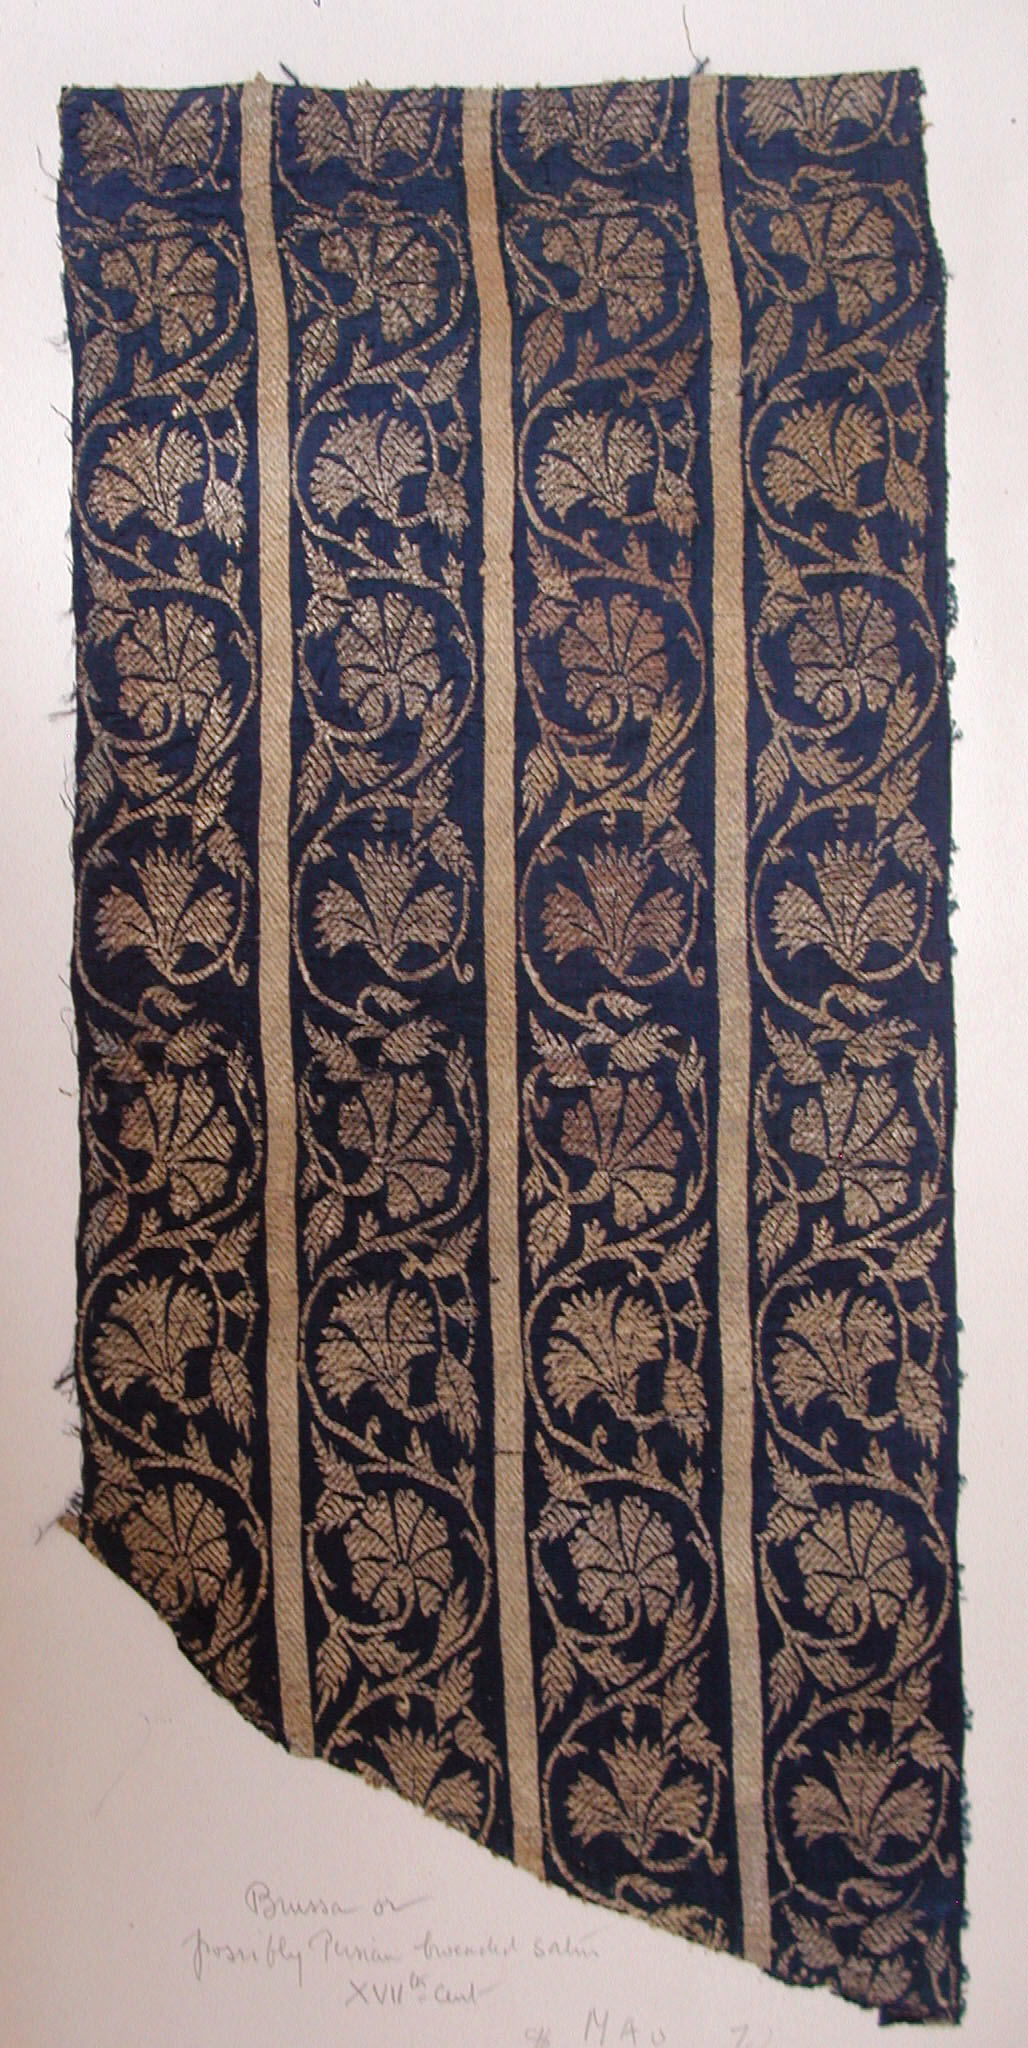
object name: textile fragment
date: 1601-1700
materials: metal thread, silk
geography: turkey or iran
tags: flowers